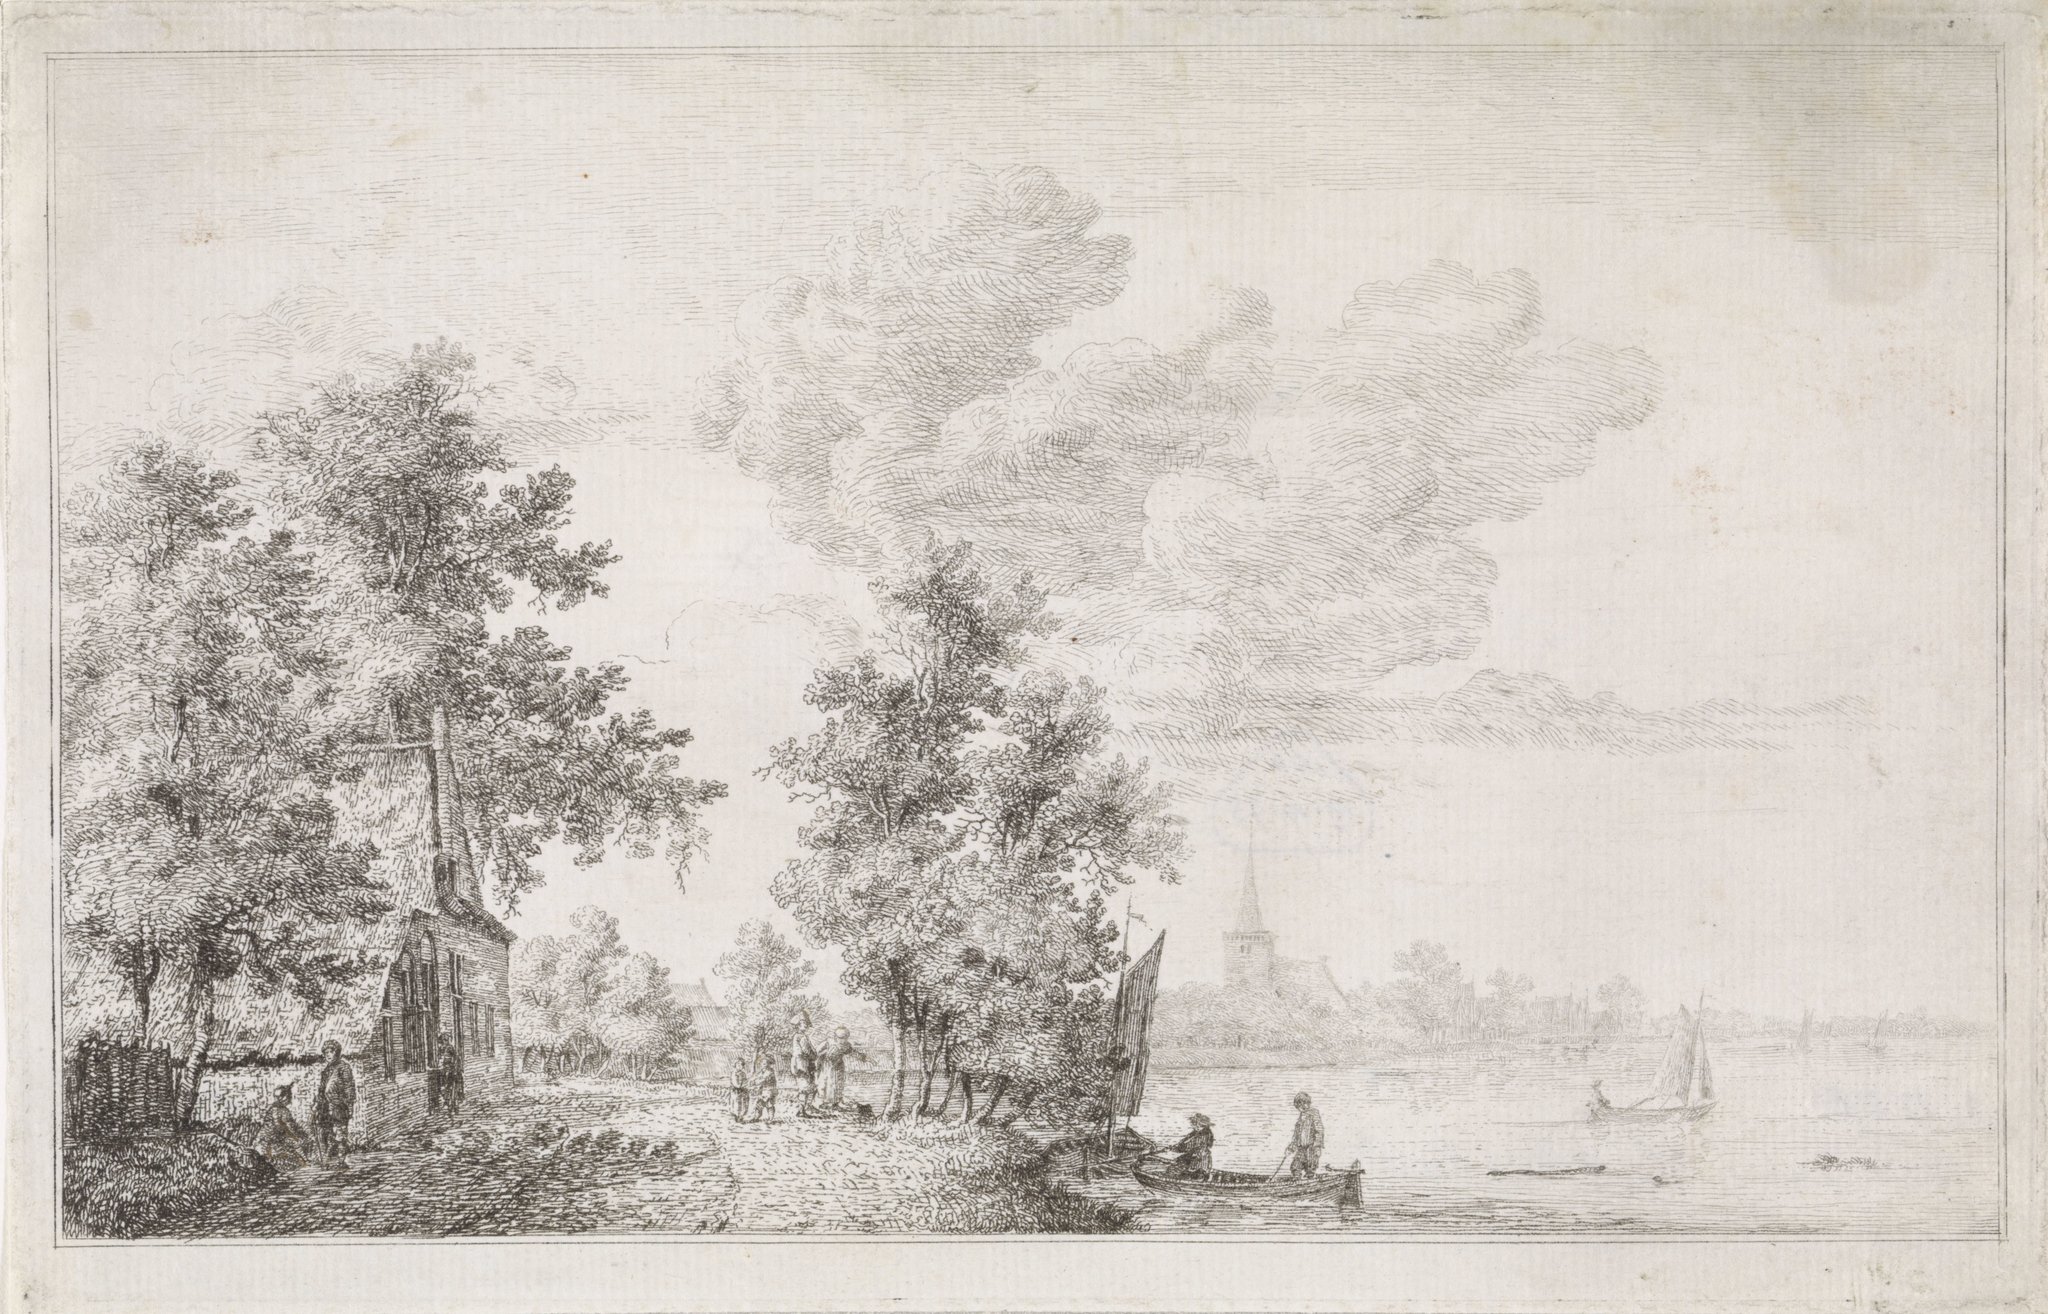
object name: print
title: Gezicht op Lekkerkerk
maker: jacobus versteegen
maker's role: draughtsman, print maker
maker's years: 1735-1795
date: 1745-1795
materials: paper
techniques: etching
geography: amsterdam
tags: river, parts of church exterior and annexes: tower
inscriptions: collector's mark: Lugt 2228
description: Gezicht op Lekkerkerk met links een weg langs een boerenwoning; rechts een rivier met aan de overzijde een kerk. Op de voorgrond een afmerende boot met twee figuren.